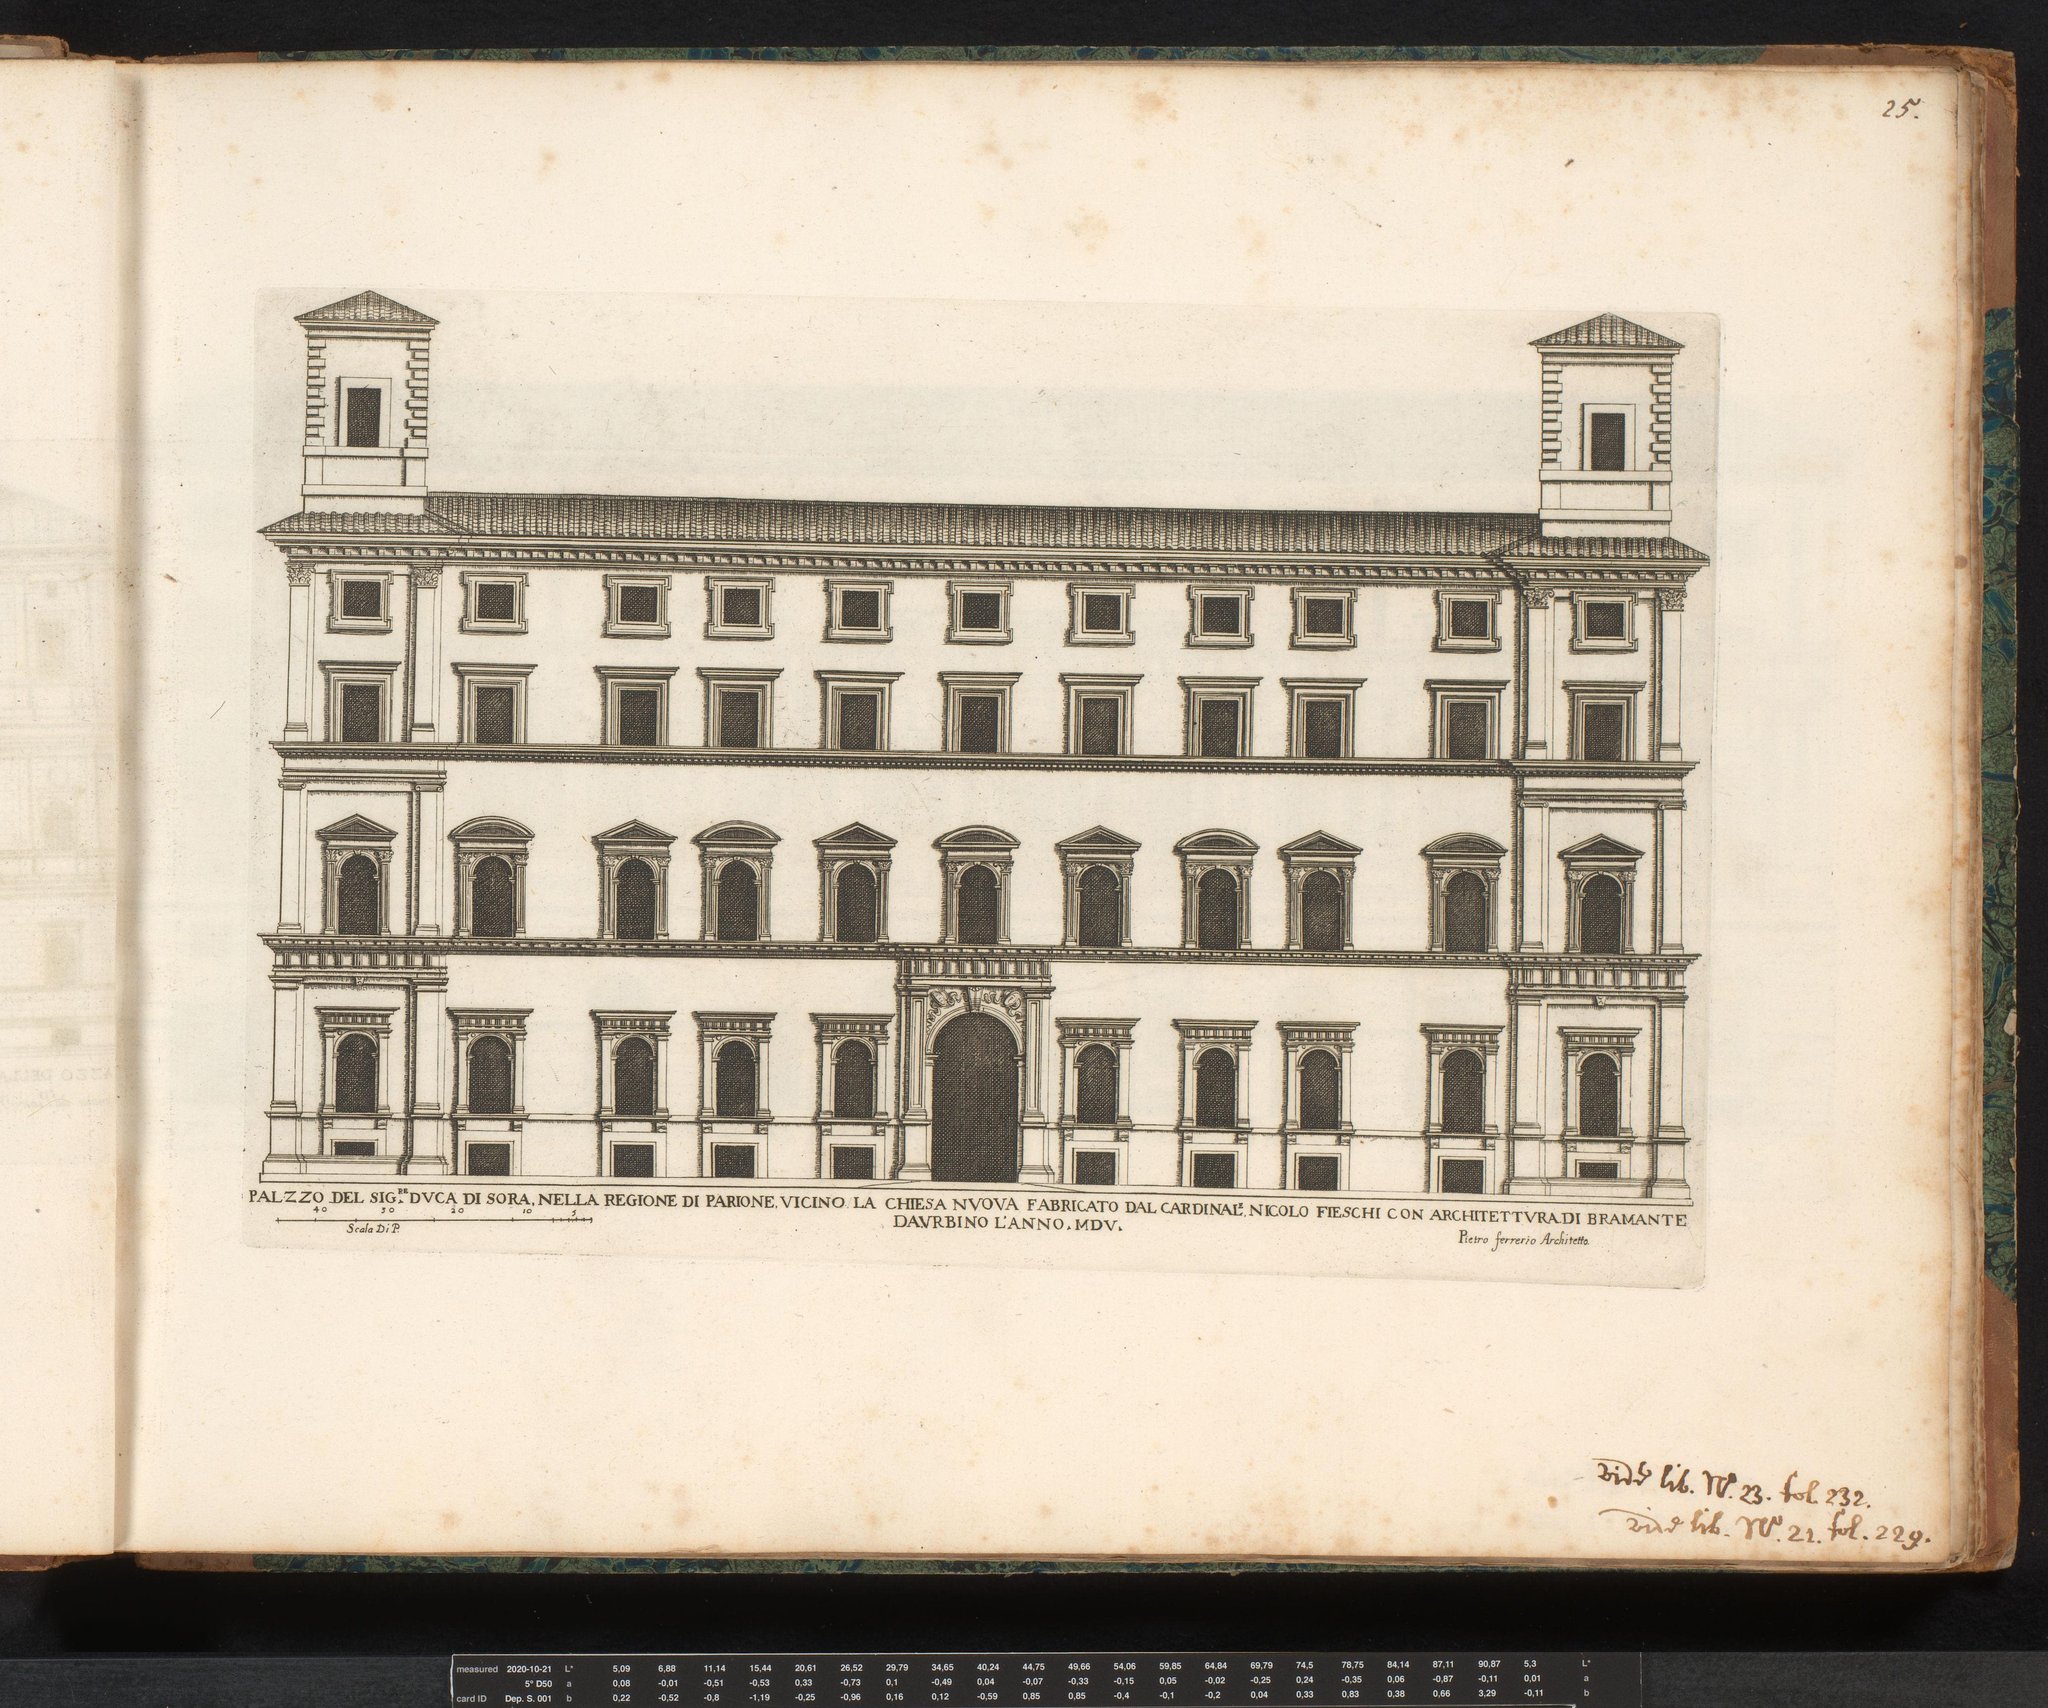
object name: album leaf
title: Romeinse paleizen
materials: paper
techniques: etching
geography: rome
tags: palace, façade (of house or building)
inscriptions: number: ‘25’, inscription: ‘Ende lib. No. 23. fol. 232./ Ende lib. No. 21. fol. 229.’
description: Deze prent maakt deel uit van de reeks getiteld: Palazzi di Roma. Deze reeks bestaat uit twee boeken. Boek één getiteld: Palazzi di Roma dei più celebri architetti..., bestaat uit 44 prenten die worden toegeschreven aan Giovanni Battista Falda (naam staat enkel op prent 27) en uitgegeven door Giovanni Giacomo de'Rossi. Deze 44 prenten zijn bekend in twee staten (met en zonder nummer). Boek twee getiteld: Nuovi disegni dell'architetture... libro secondo, bevat 66 prenten door Giovanni Battista Falda en Simone Felice. Deze 66 prenten zijn bekend in twee staten (met en zonder nummer).